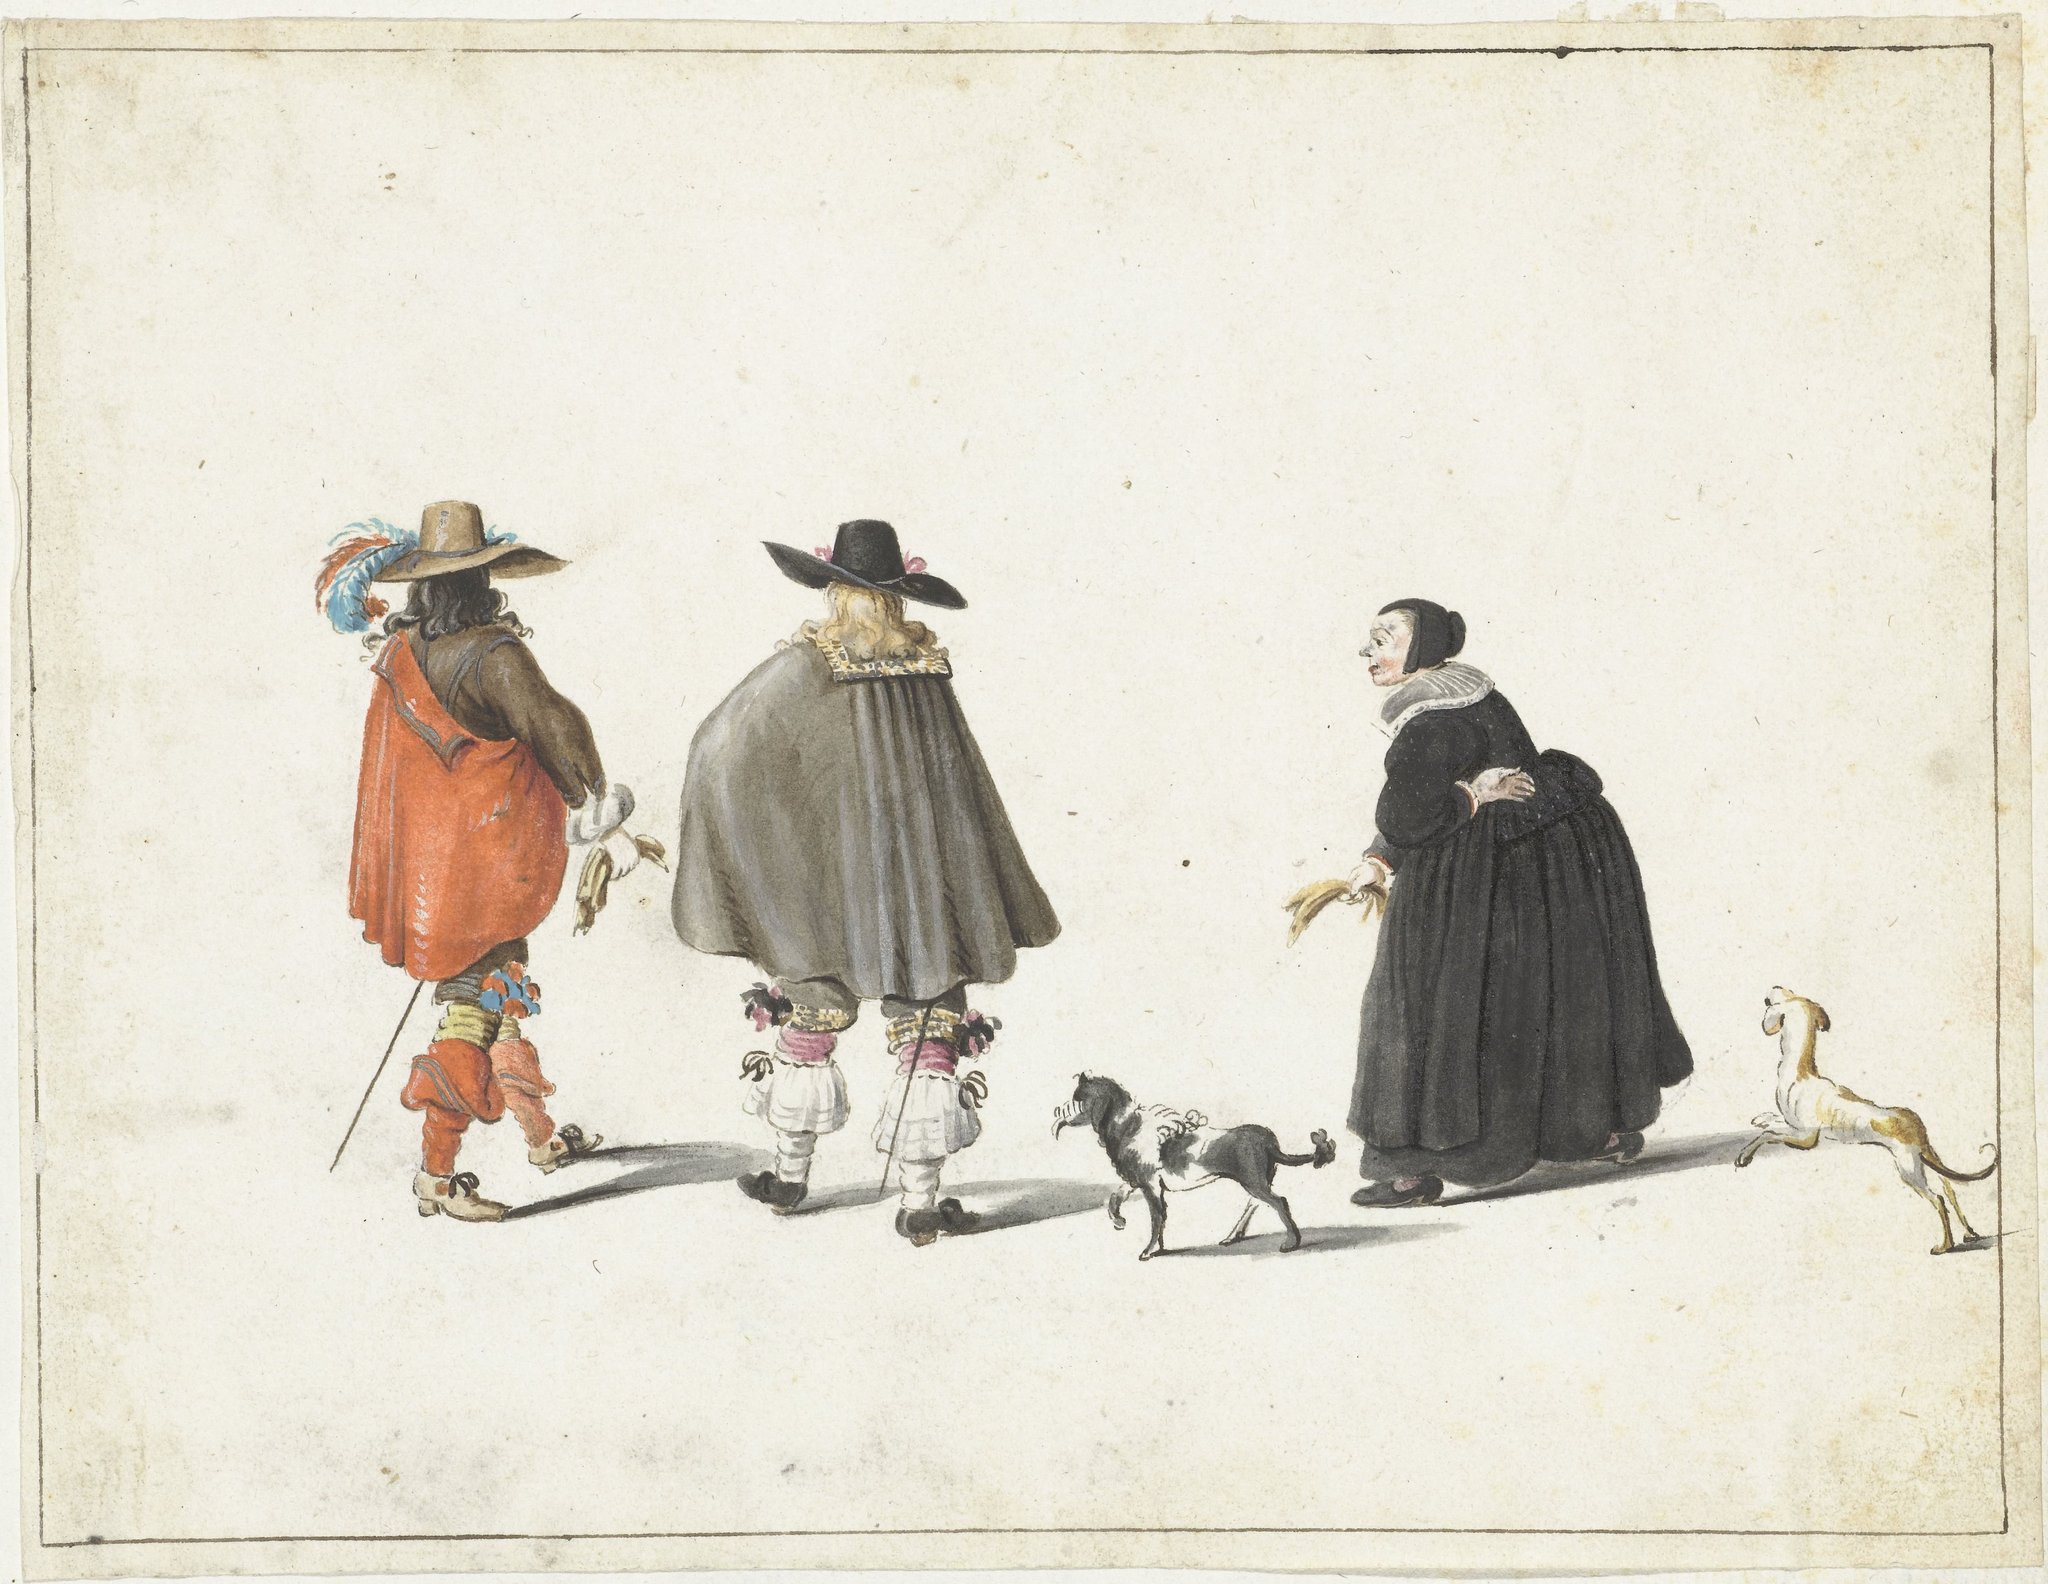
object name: watercolor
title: Vrouw in zwart, vergezeld door twee hondjes, pratend met twee heren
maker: gesina ter borch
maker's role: draughtsman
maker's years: 1633-1690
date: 1654-1655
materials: ink, paper, watercolor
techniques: brush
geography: zwolle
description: Tekening opgeplakt naast drie andere tekeningen in Familie-plakboek. Maakte mogelijk deel uit van een serie of schetsboek.